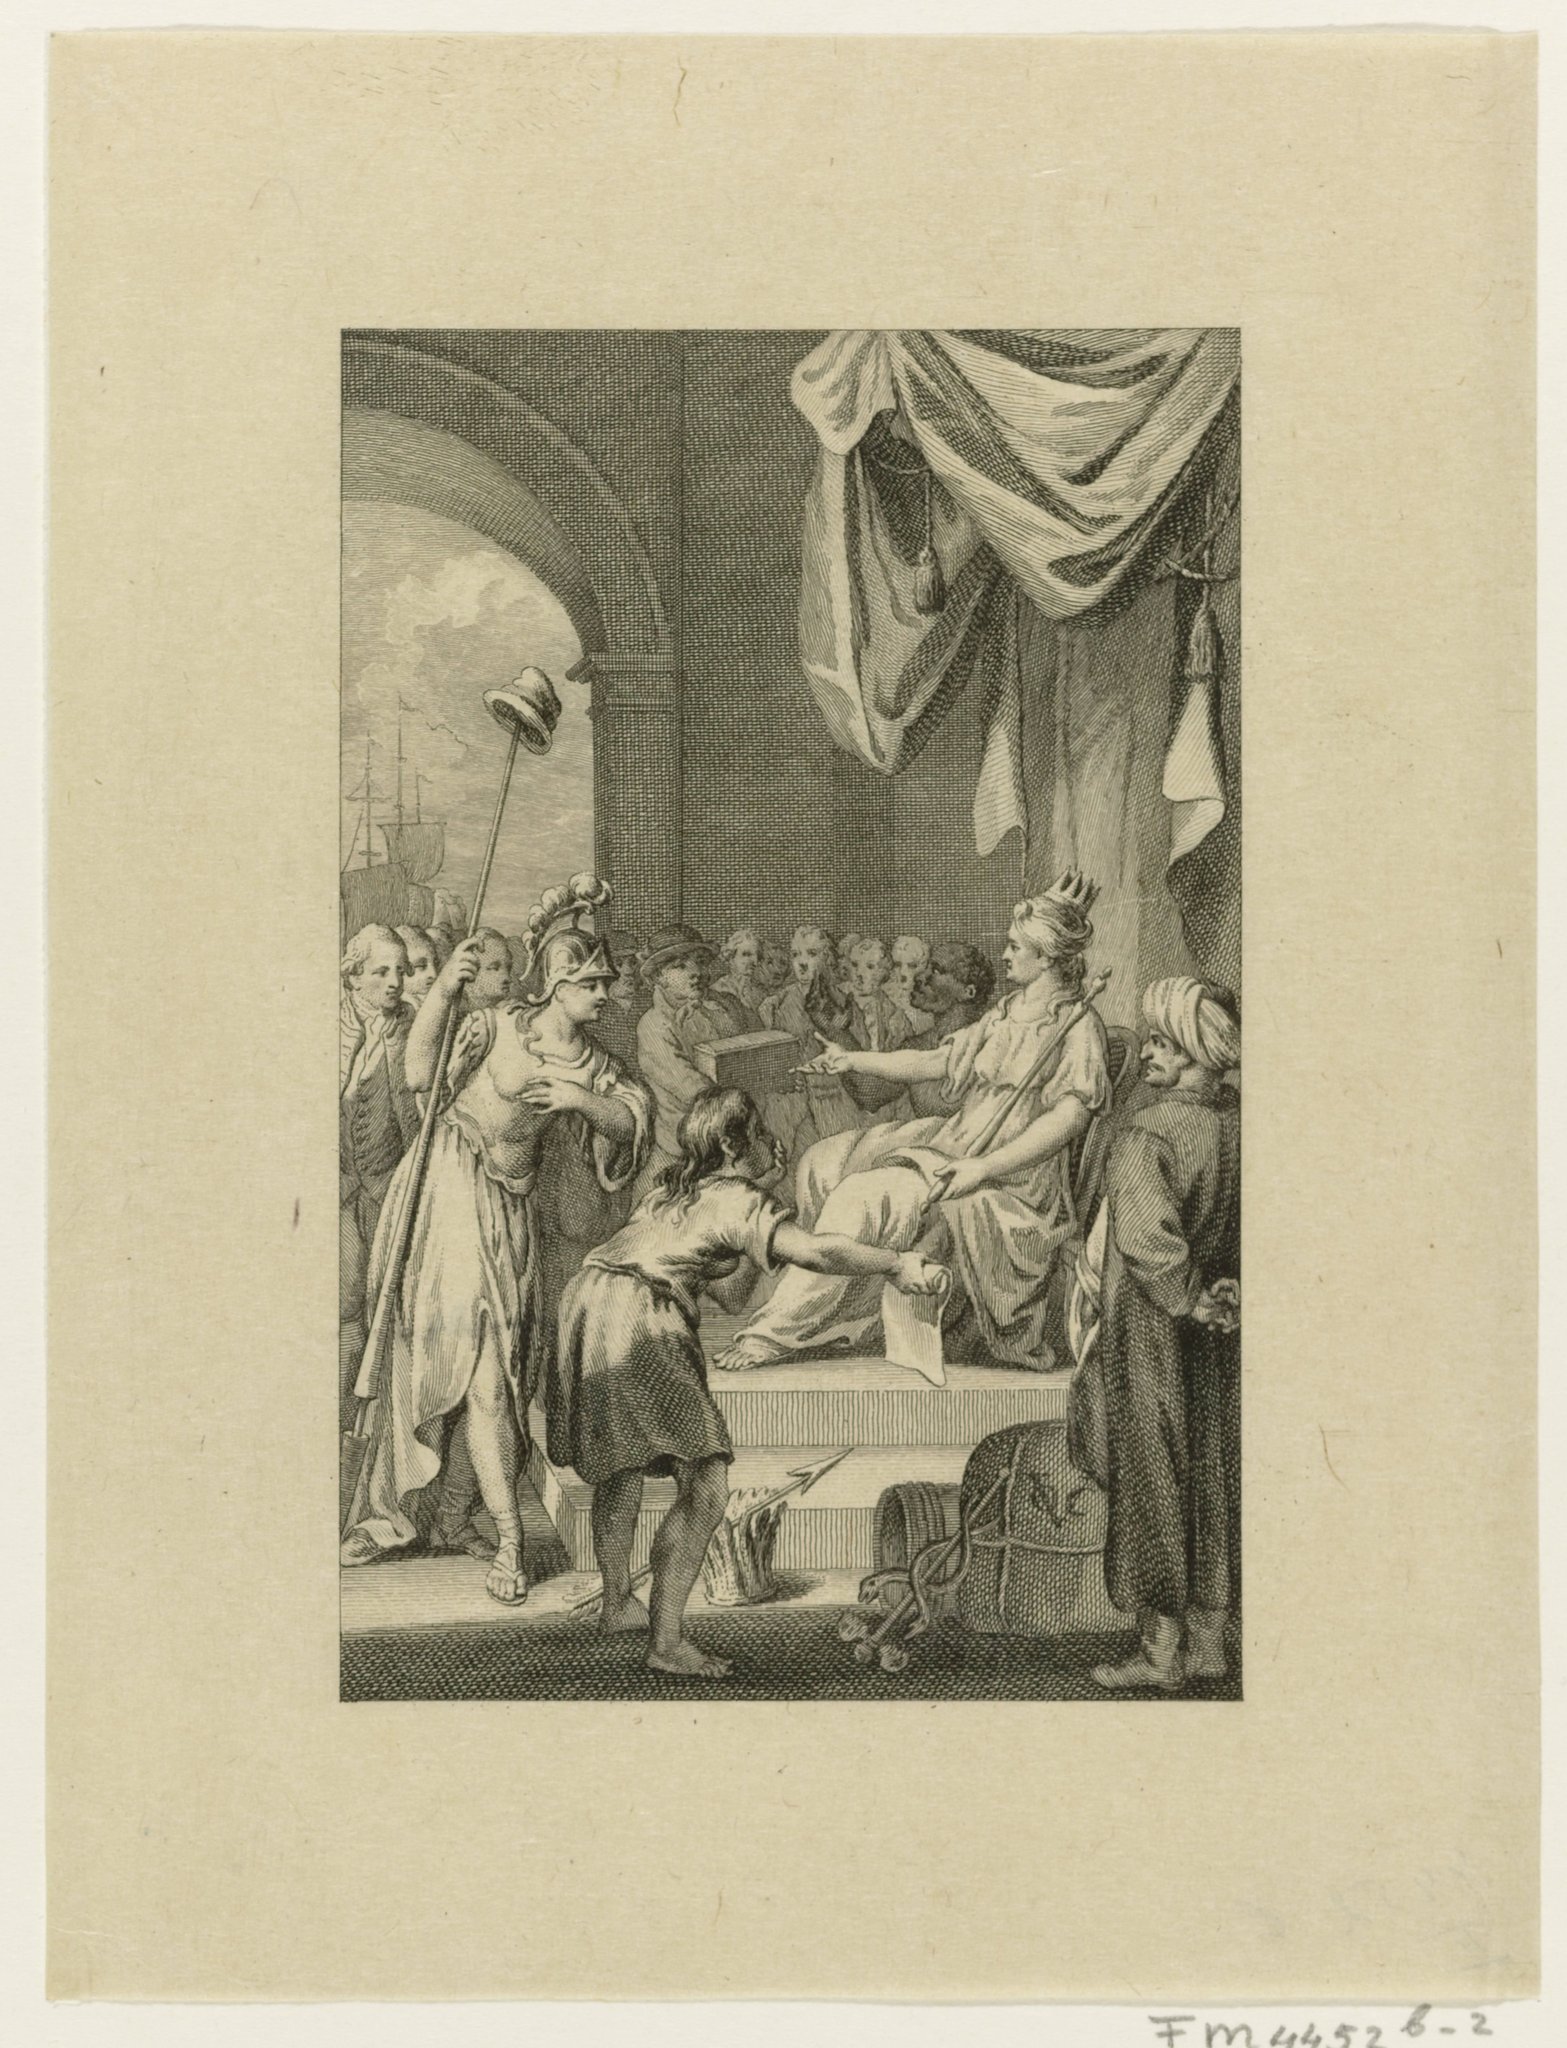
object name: print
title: De Nederlandse Maagd bericht over de overwinning, 1781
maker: reinier vinkeles (i)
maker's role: draughtsman, print maker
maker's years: 1741-1816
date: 1782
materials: paper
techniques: engraving, etching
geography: northern netherlands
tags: personifications of countries, nations, states, districts, etc., netherlands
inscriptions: collector's mark: Lugt 2228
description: Allegorie op de Zeeslag bij Doggersbank tussen de Nederlandse en de Britse vloot op 5 augustus 1781. De Nederlandse Maagd bericht aan de zittende vrouwelijke personificatie van de Wereld over de overwinning in de zeeslag.